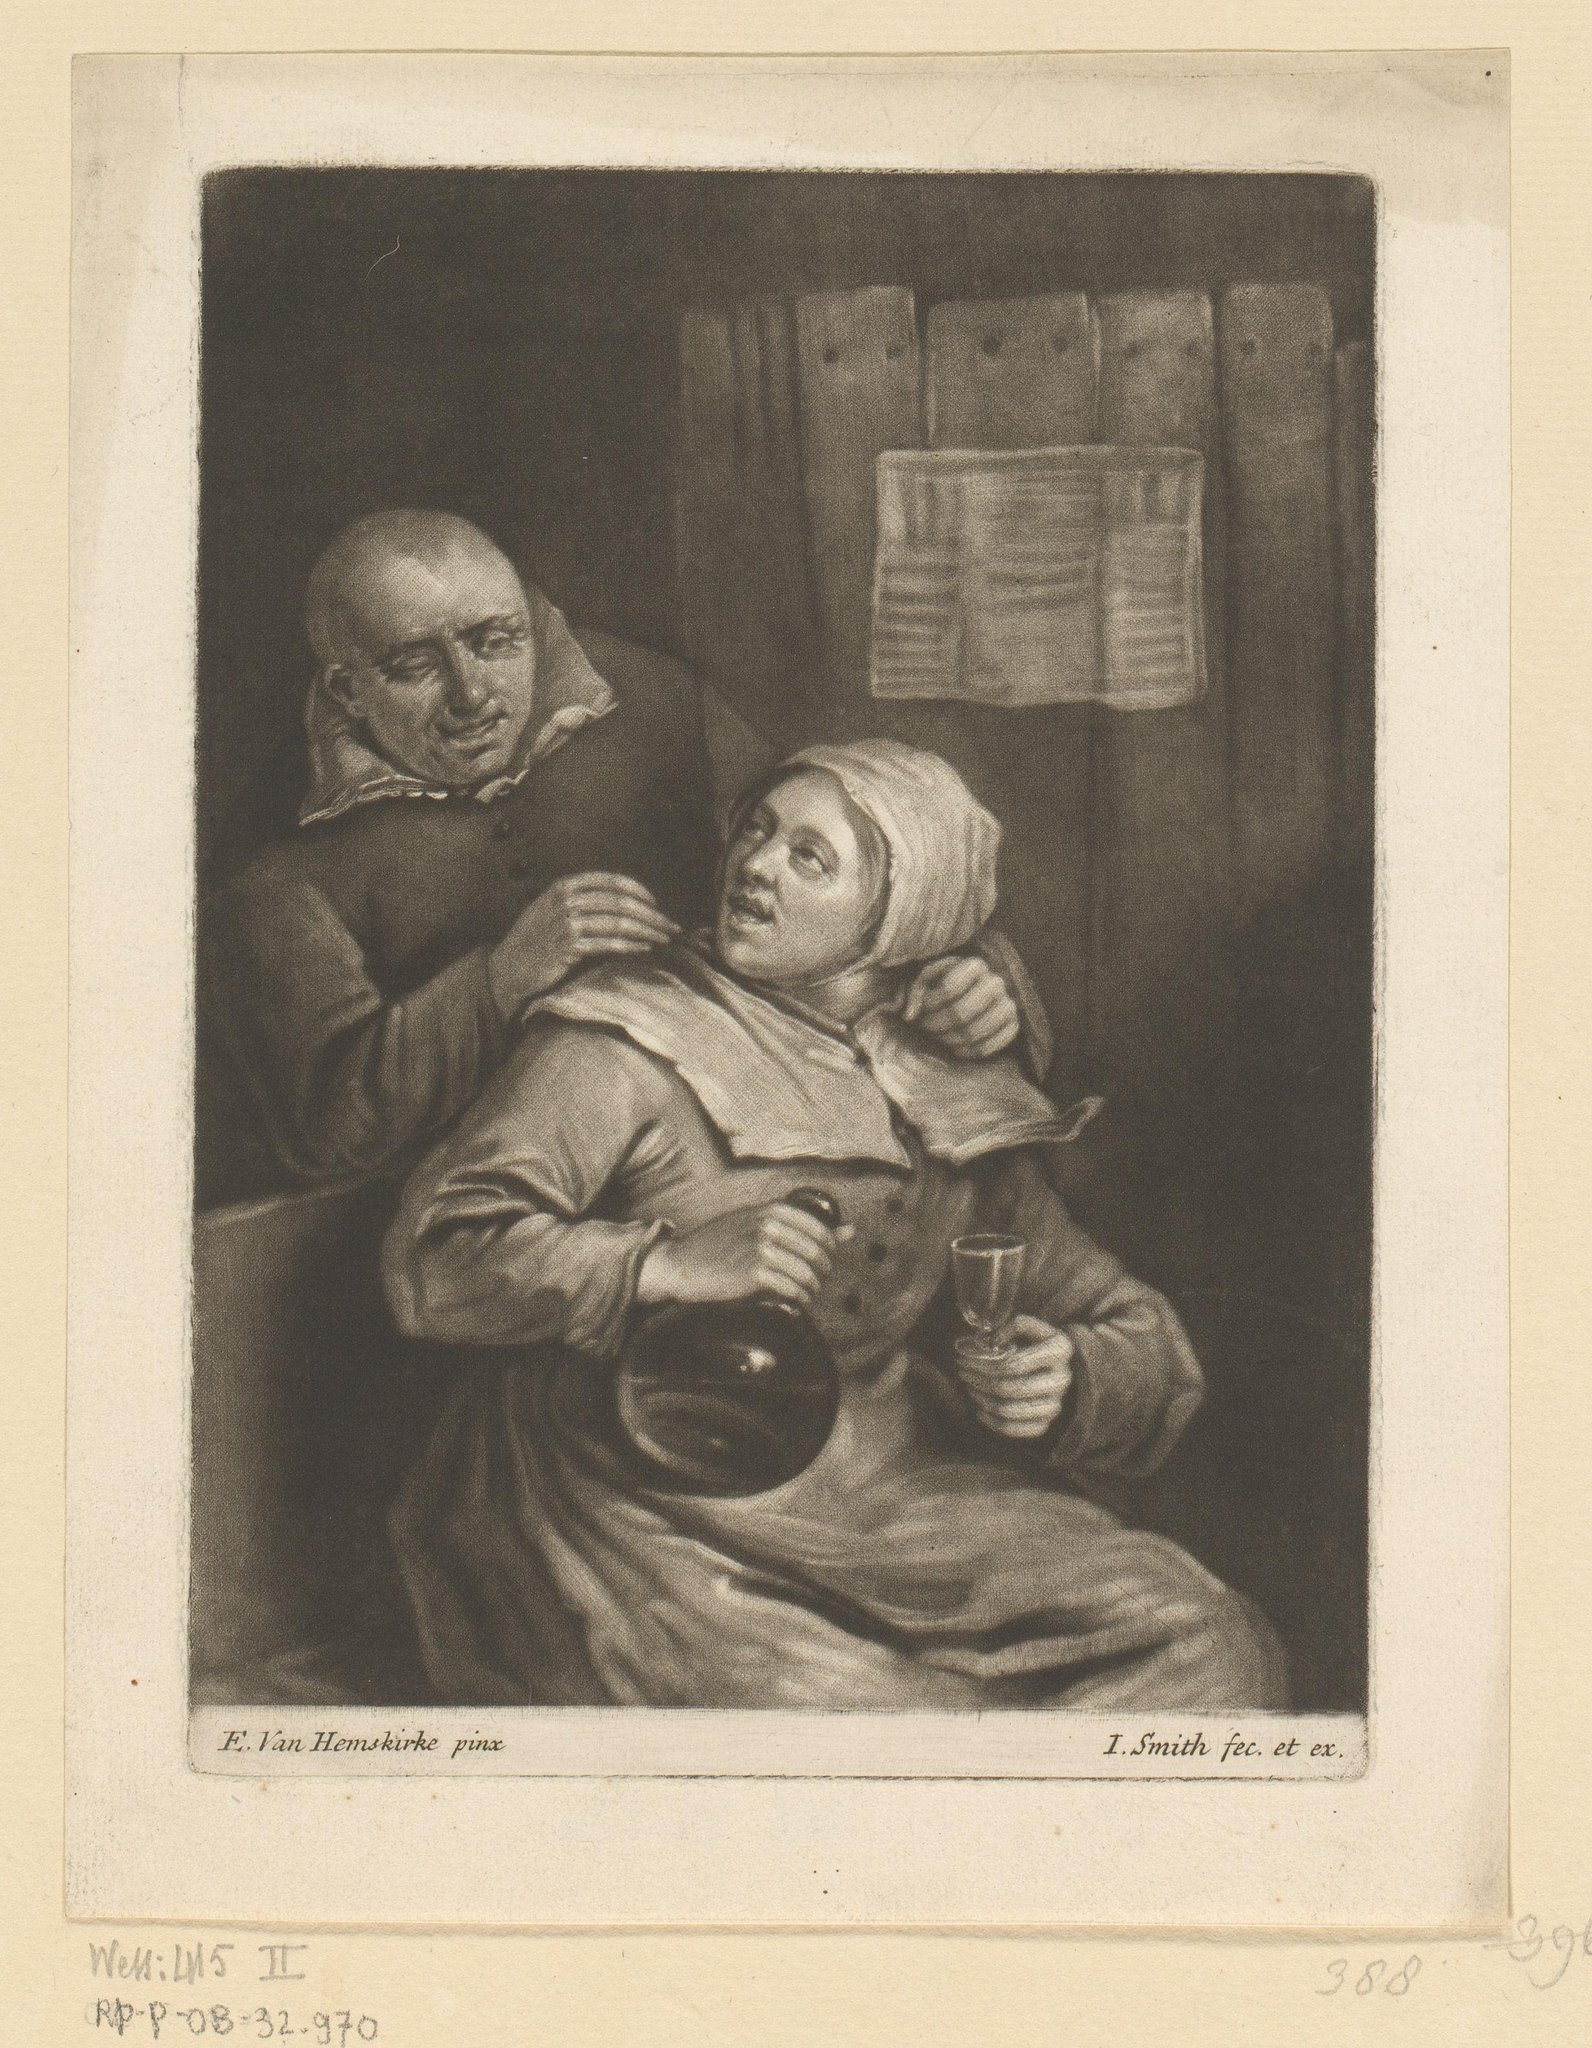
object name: print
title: Man en vrouw in een herberg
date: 1662-1706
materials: paper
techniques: mezzotint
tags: hotel, hostelry, inn, couple of lovers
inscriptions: collector's mark: Lugt 240